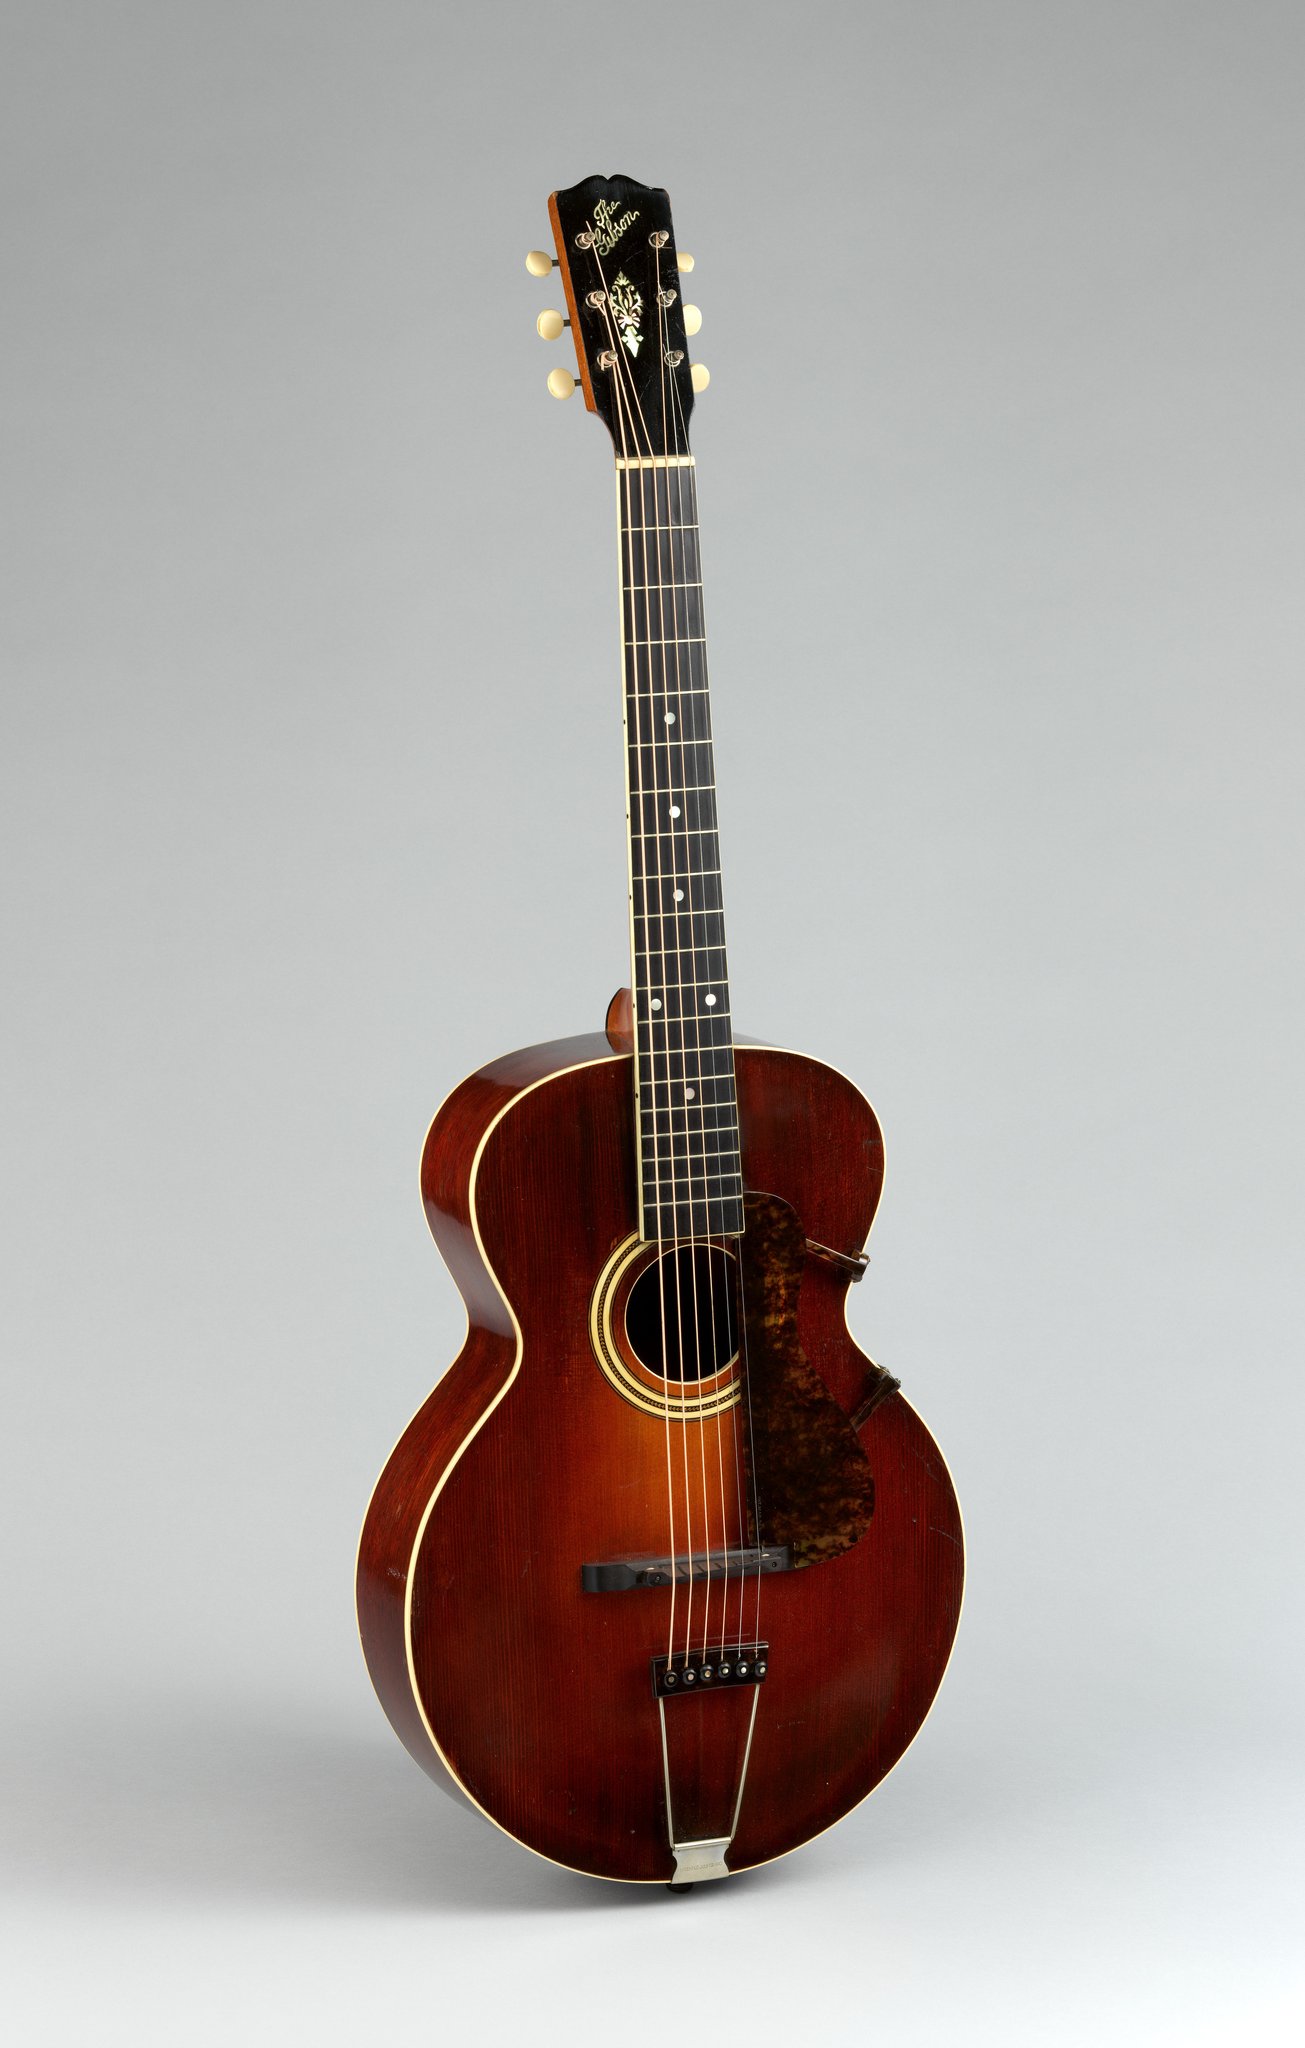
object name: archtop guitar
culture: american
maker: gibson mandolin-guitar manufacturing co., ltd.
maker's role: maker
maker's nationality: american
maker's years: 1902-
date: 1917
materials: wood, mother of pearl, nickel, silver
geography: united states